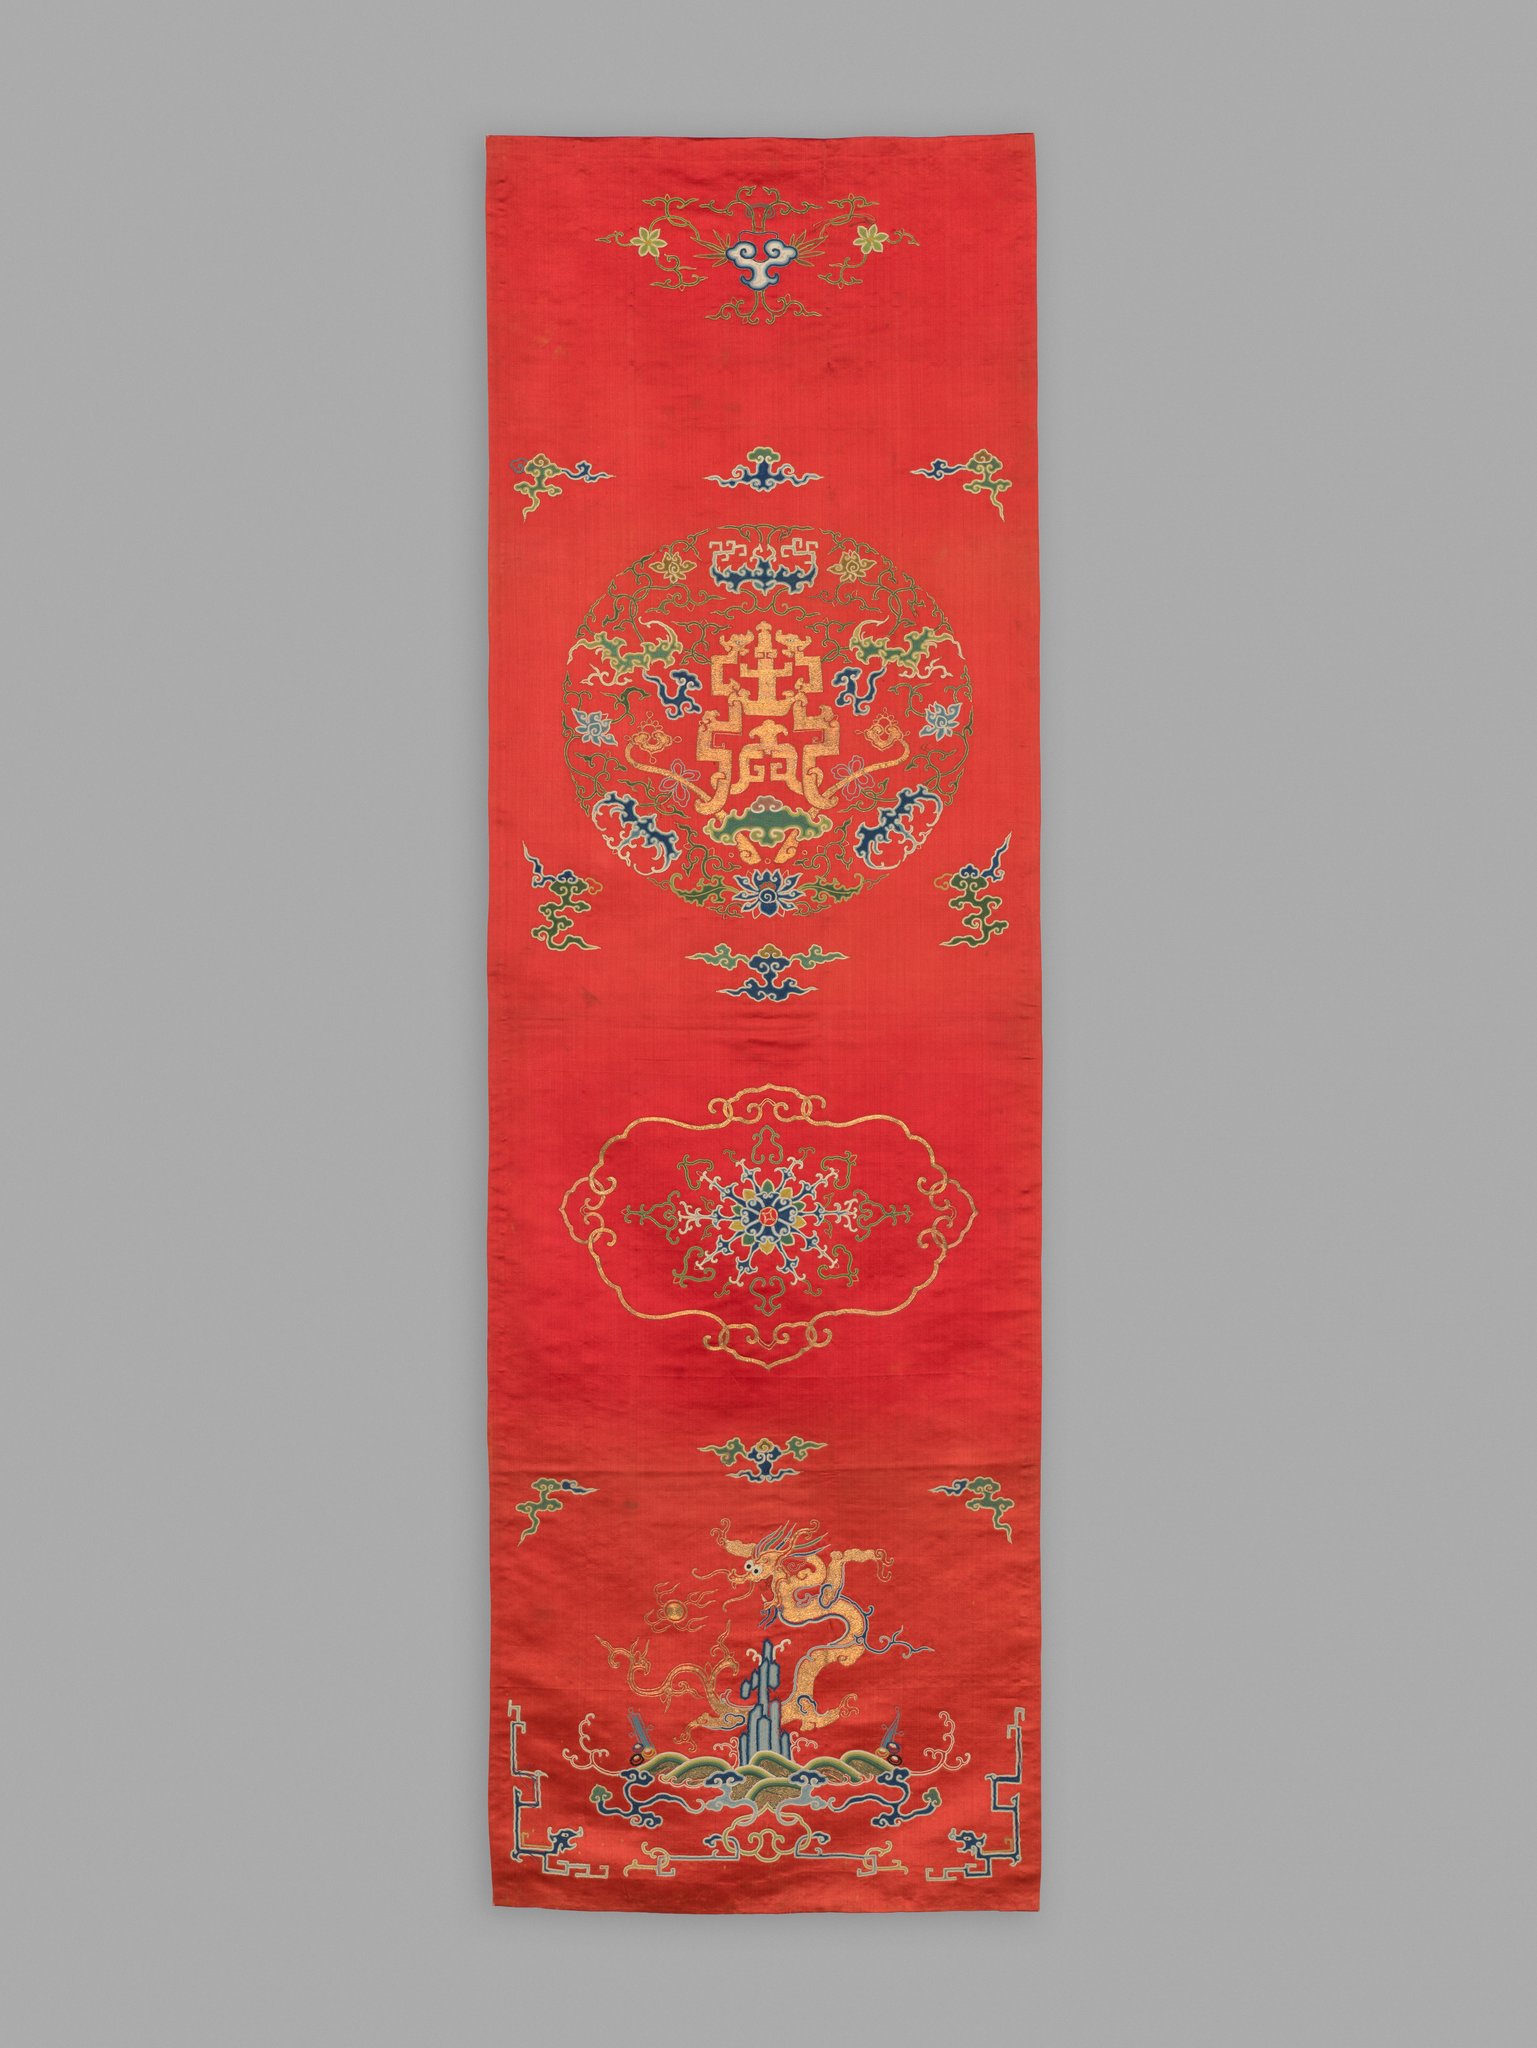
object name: chair strip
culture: chinese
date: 1662-1735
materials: metal thread, silk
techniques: embroidery